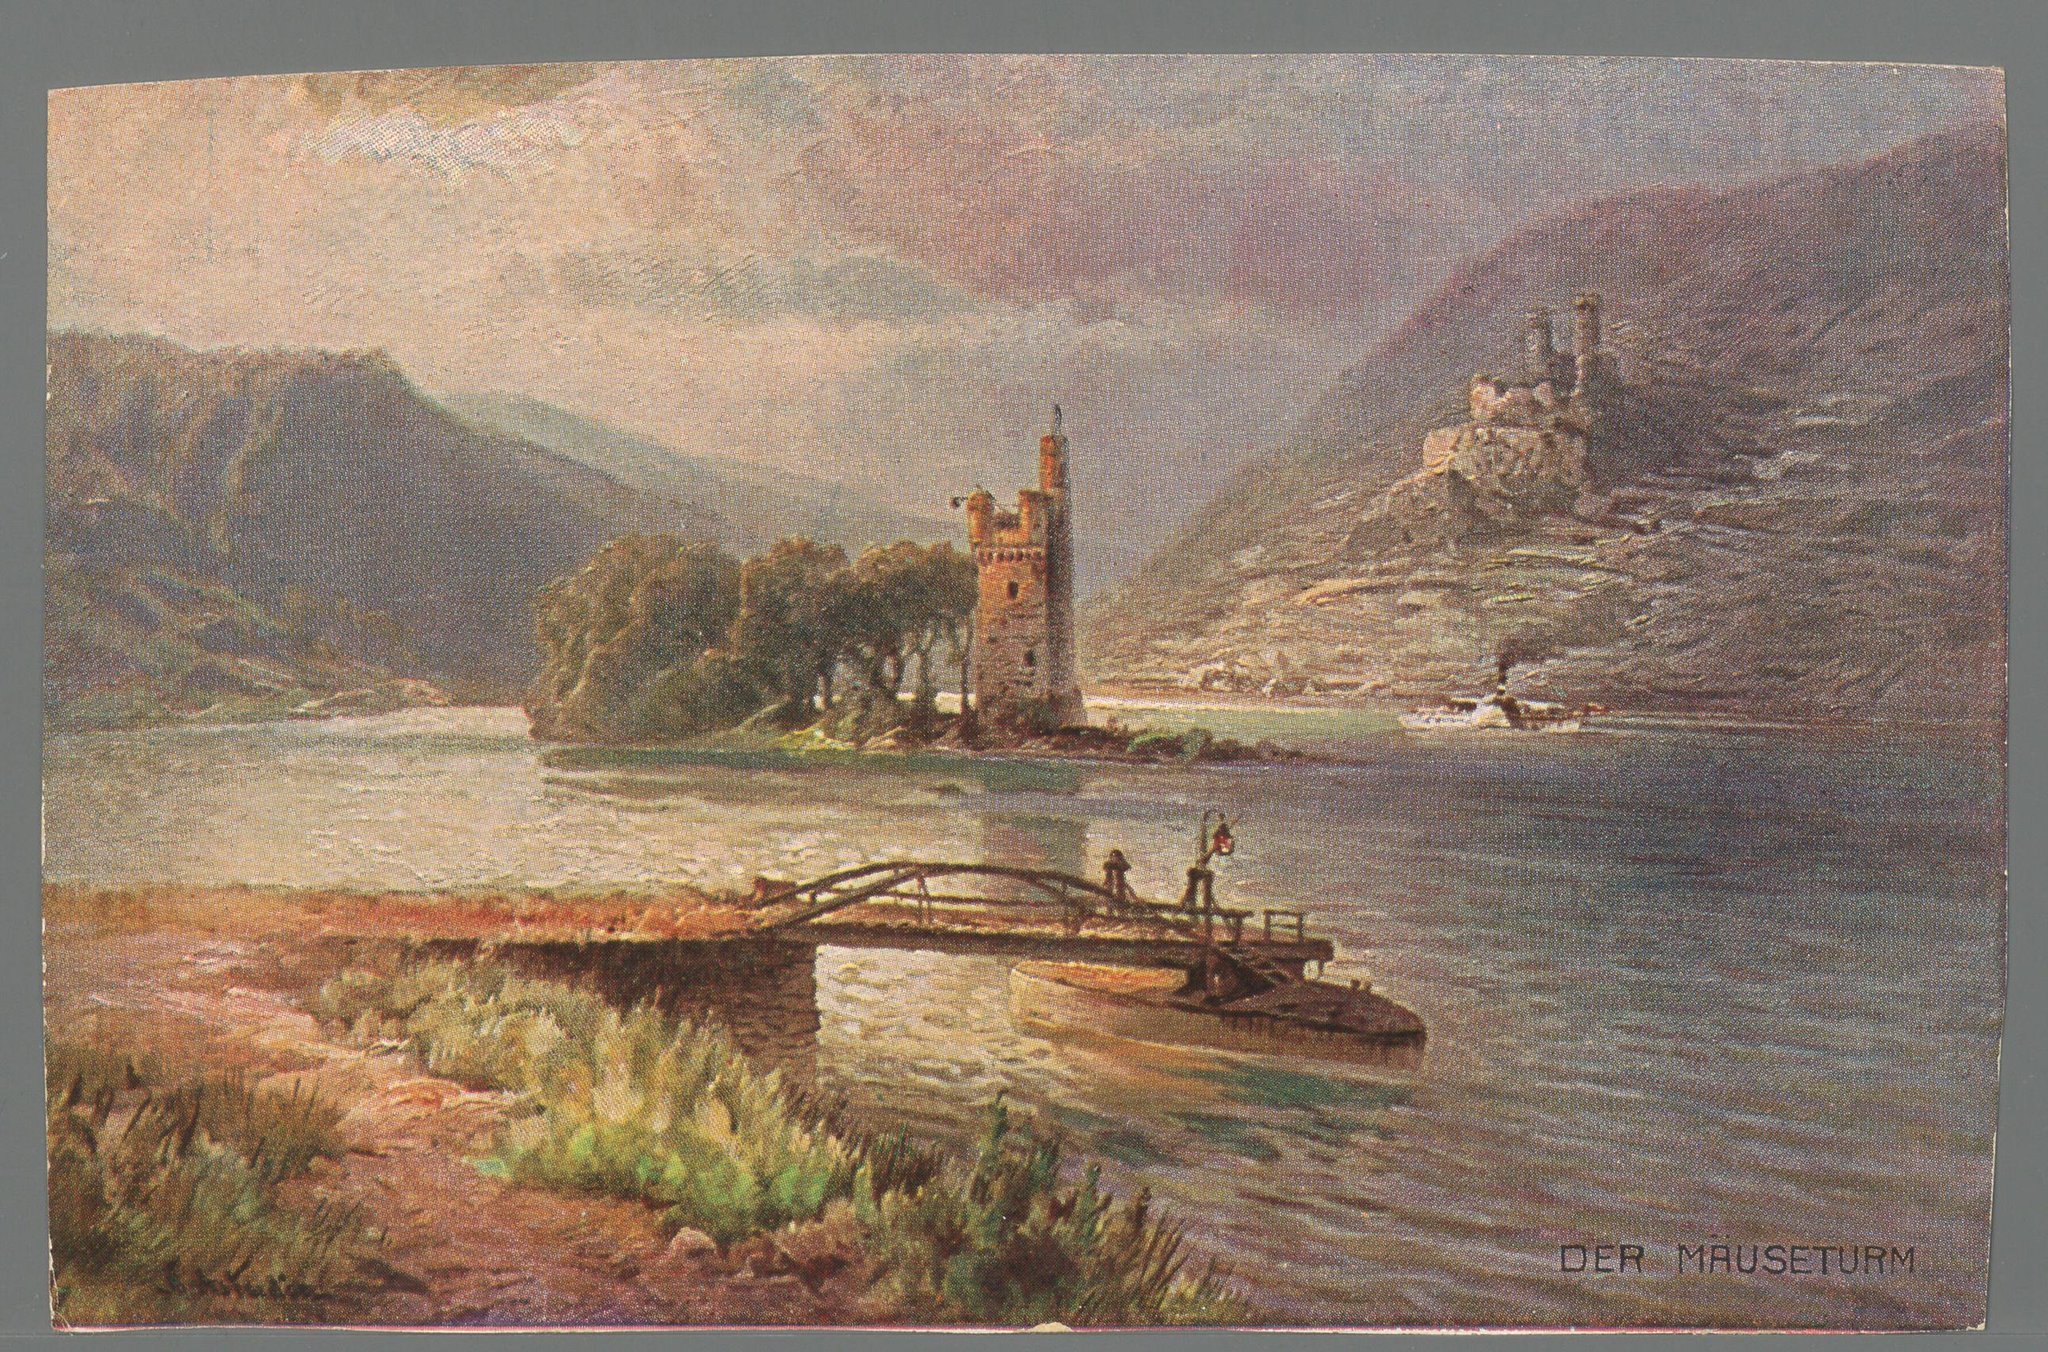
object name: photomechanical print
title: Astudin-Karten vom Rhein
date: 1905-1930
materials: cardboard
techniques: color autotype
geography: cologne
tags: towers ~ fortified city, canals, waters (in city)